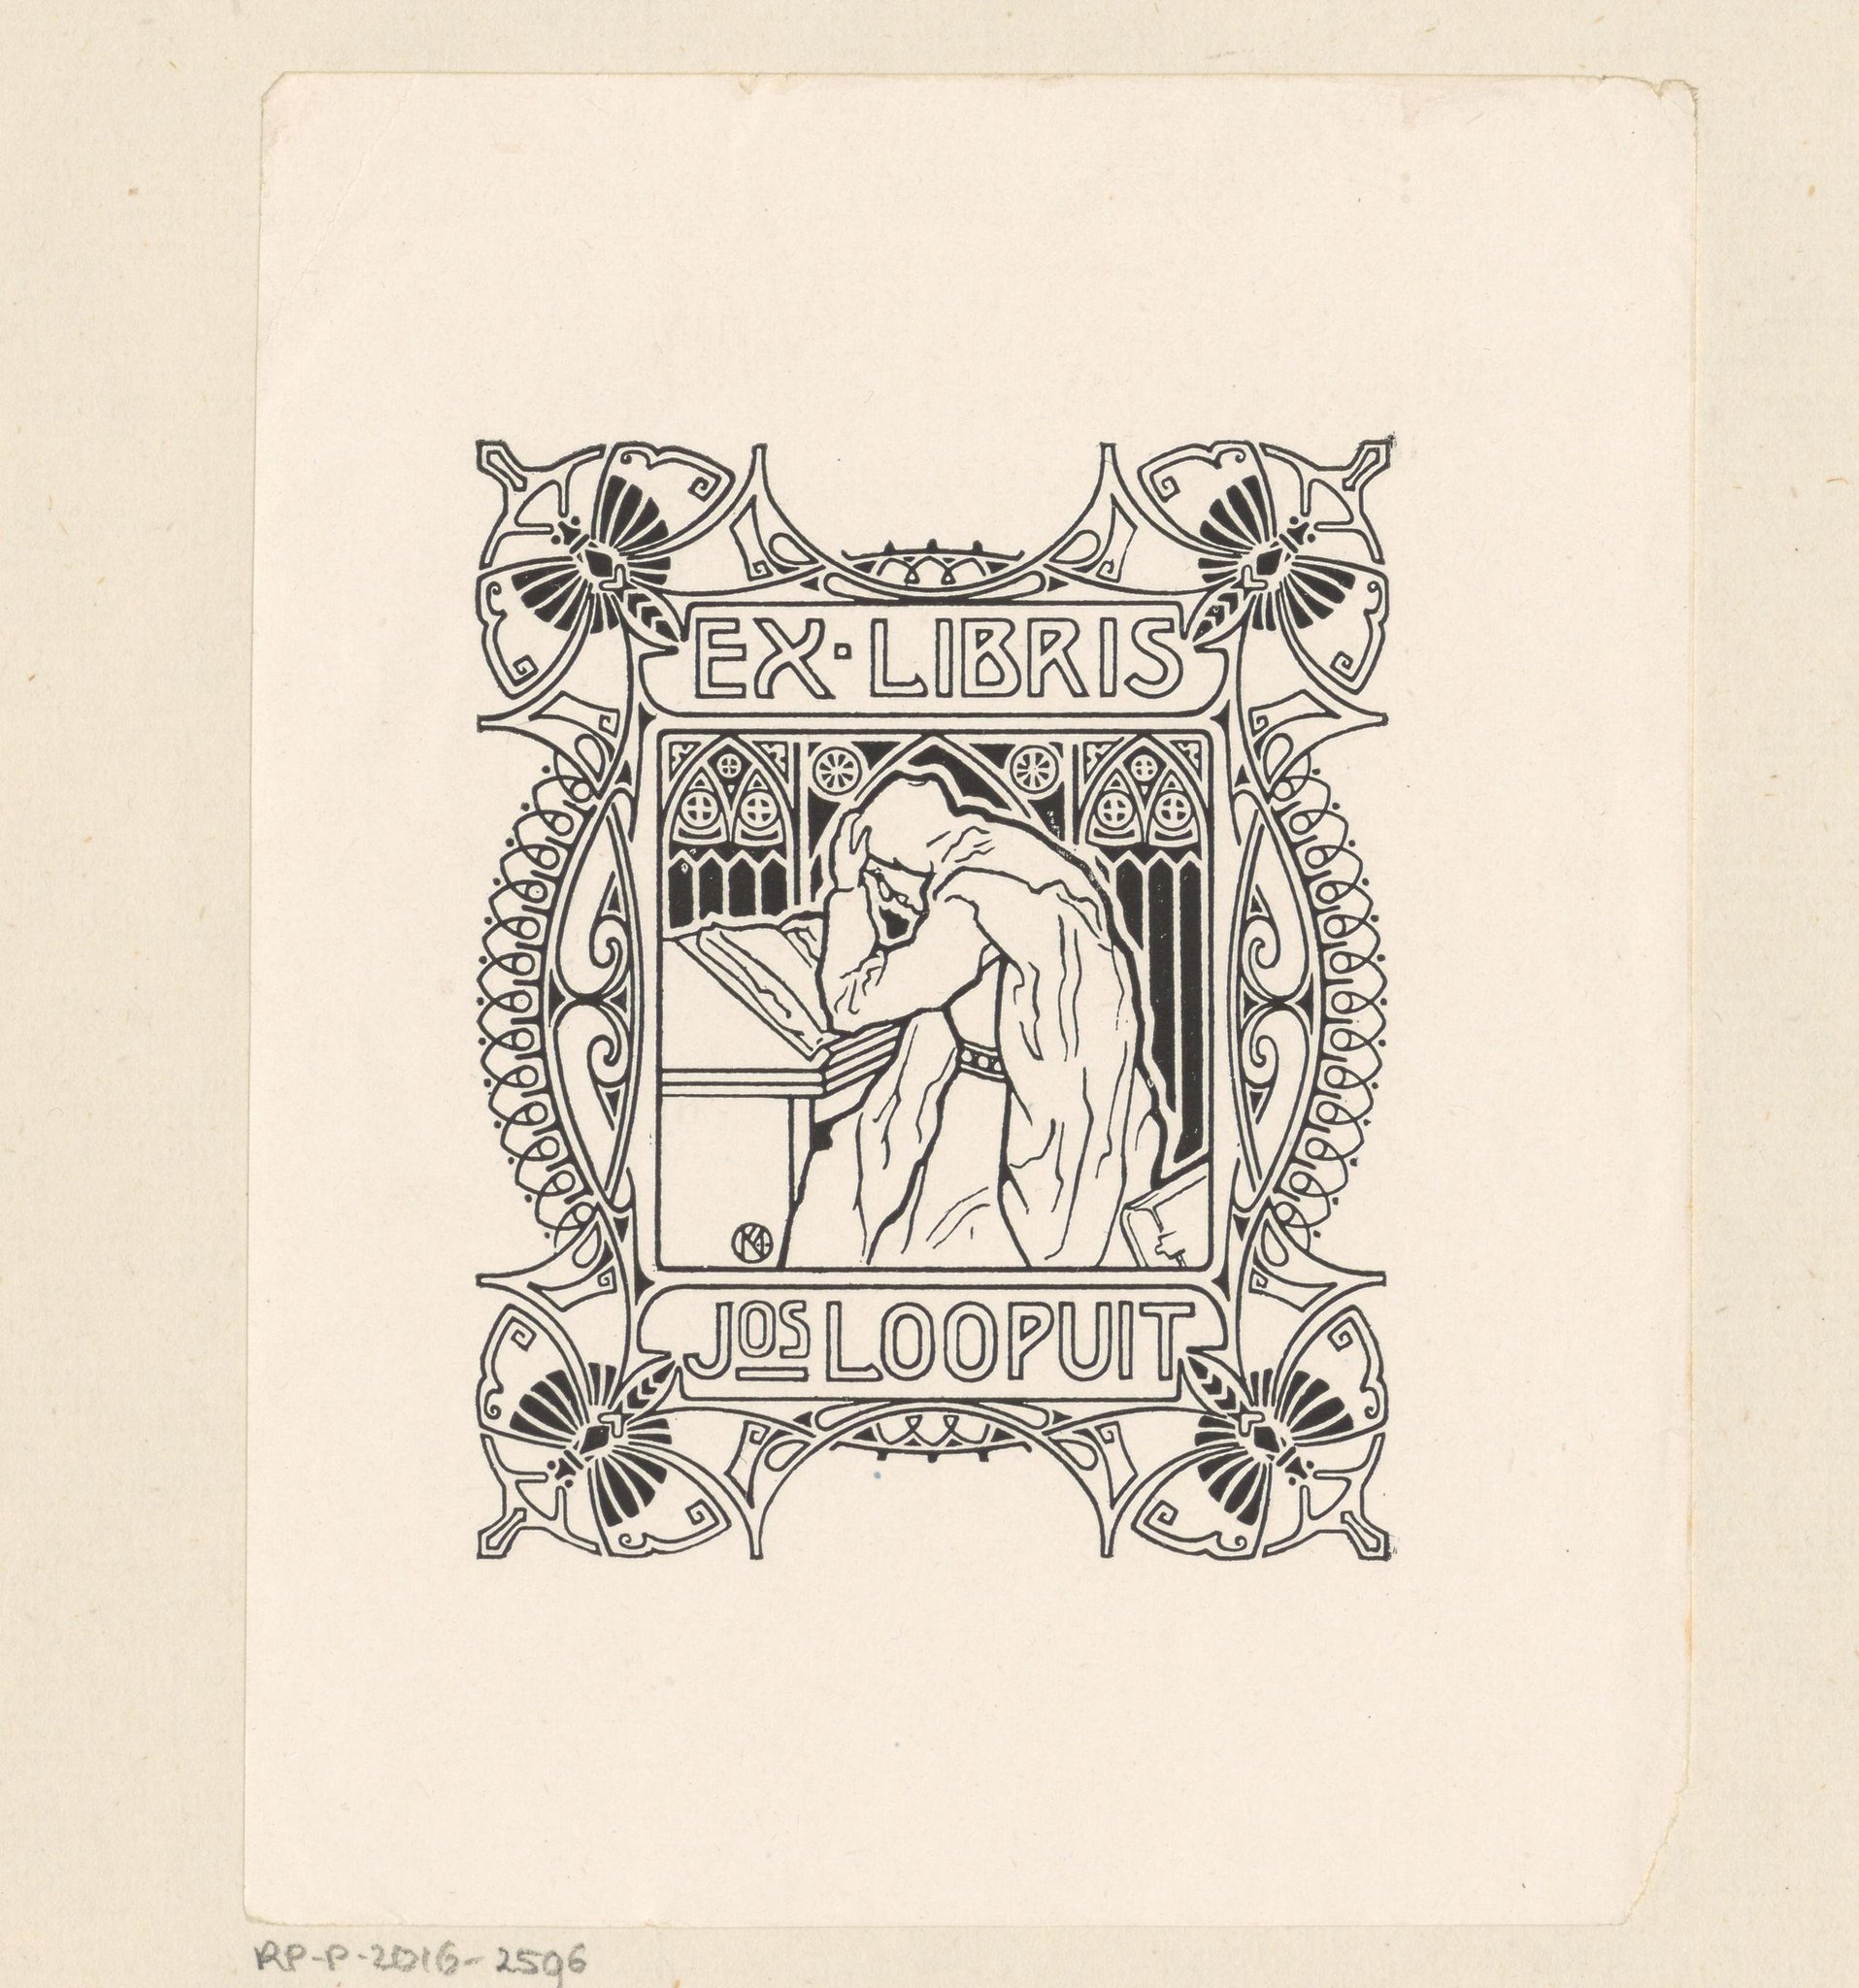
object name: bookplate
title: Ex libris van Jos Loopuit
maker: Anonymous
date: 1874-1923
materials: paper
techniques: printing block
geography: netherlands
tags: amsterdam, politician, abbey, monastery, convent ~ roman catholic church, monk(s), friar(s)